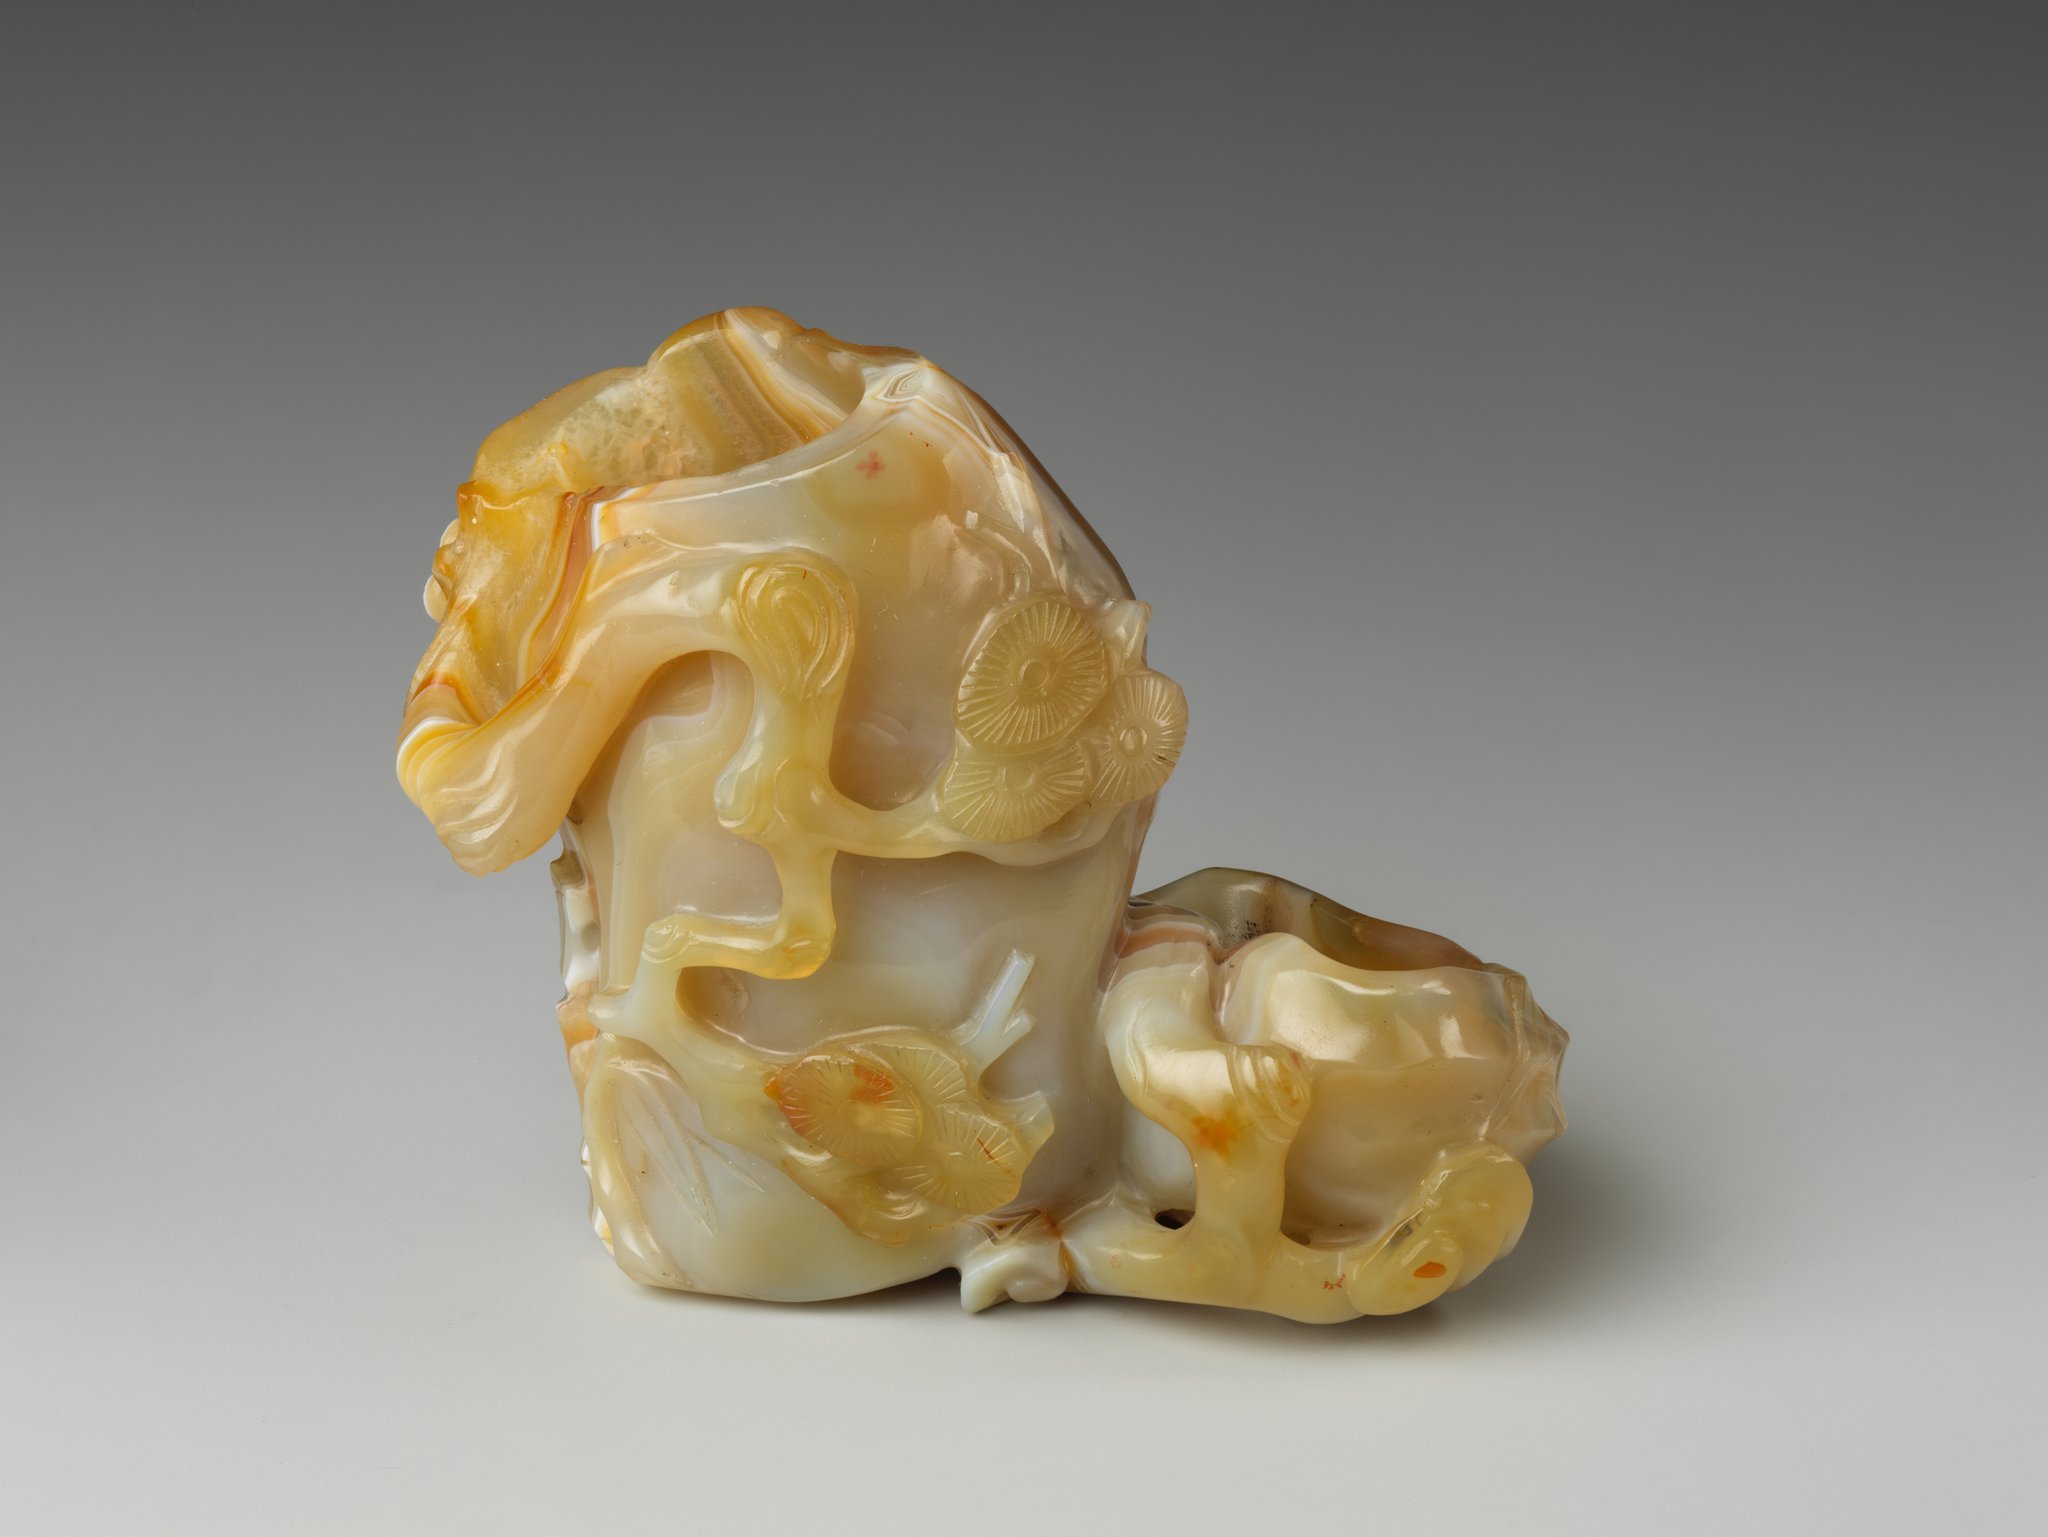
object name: vase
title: Plum-tree vase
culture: chinese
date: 1701-1800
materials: stone